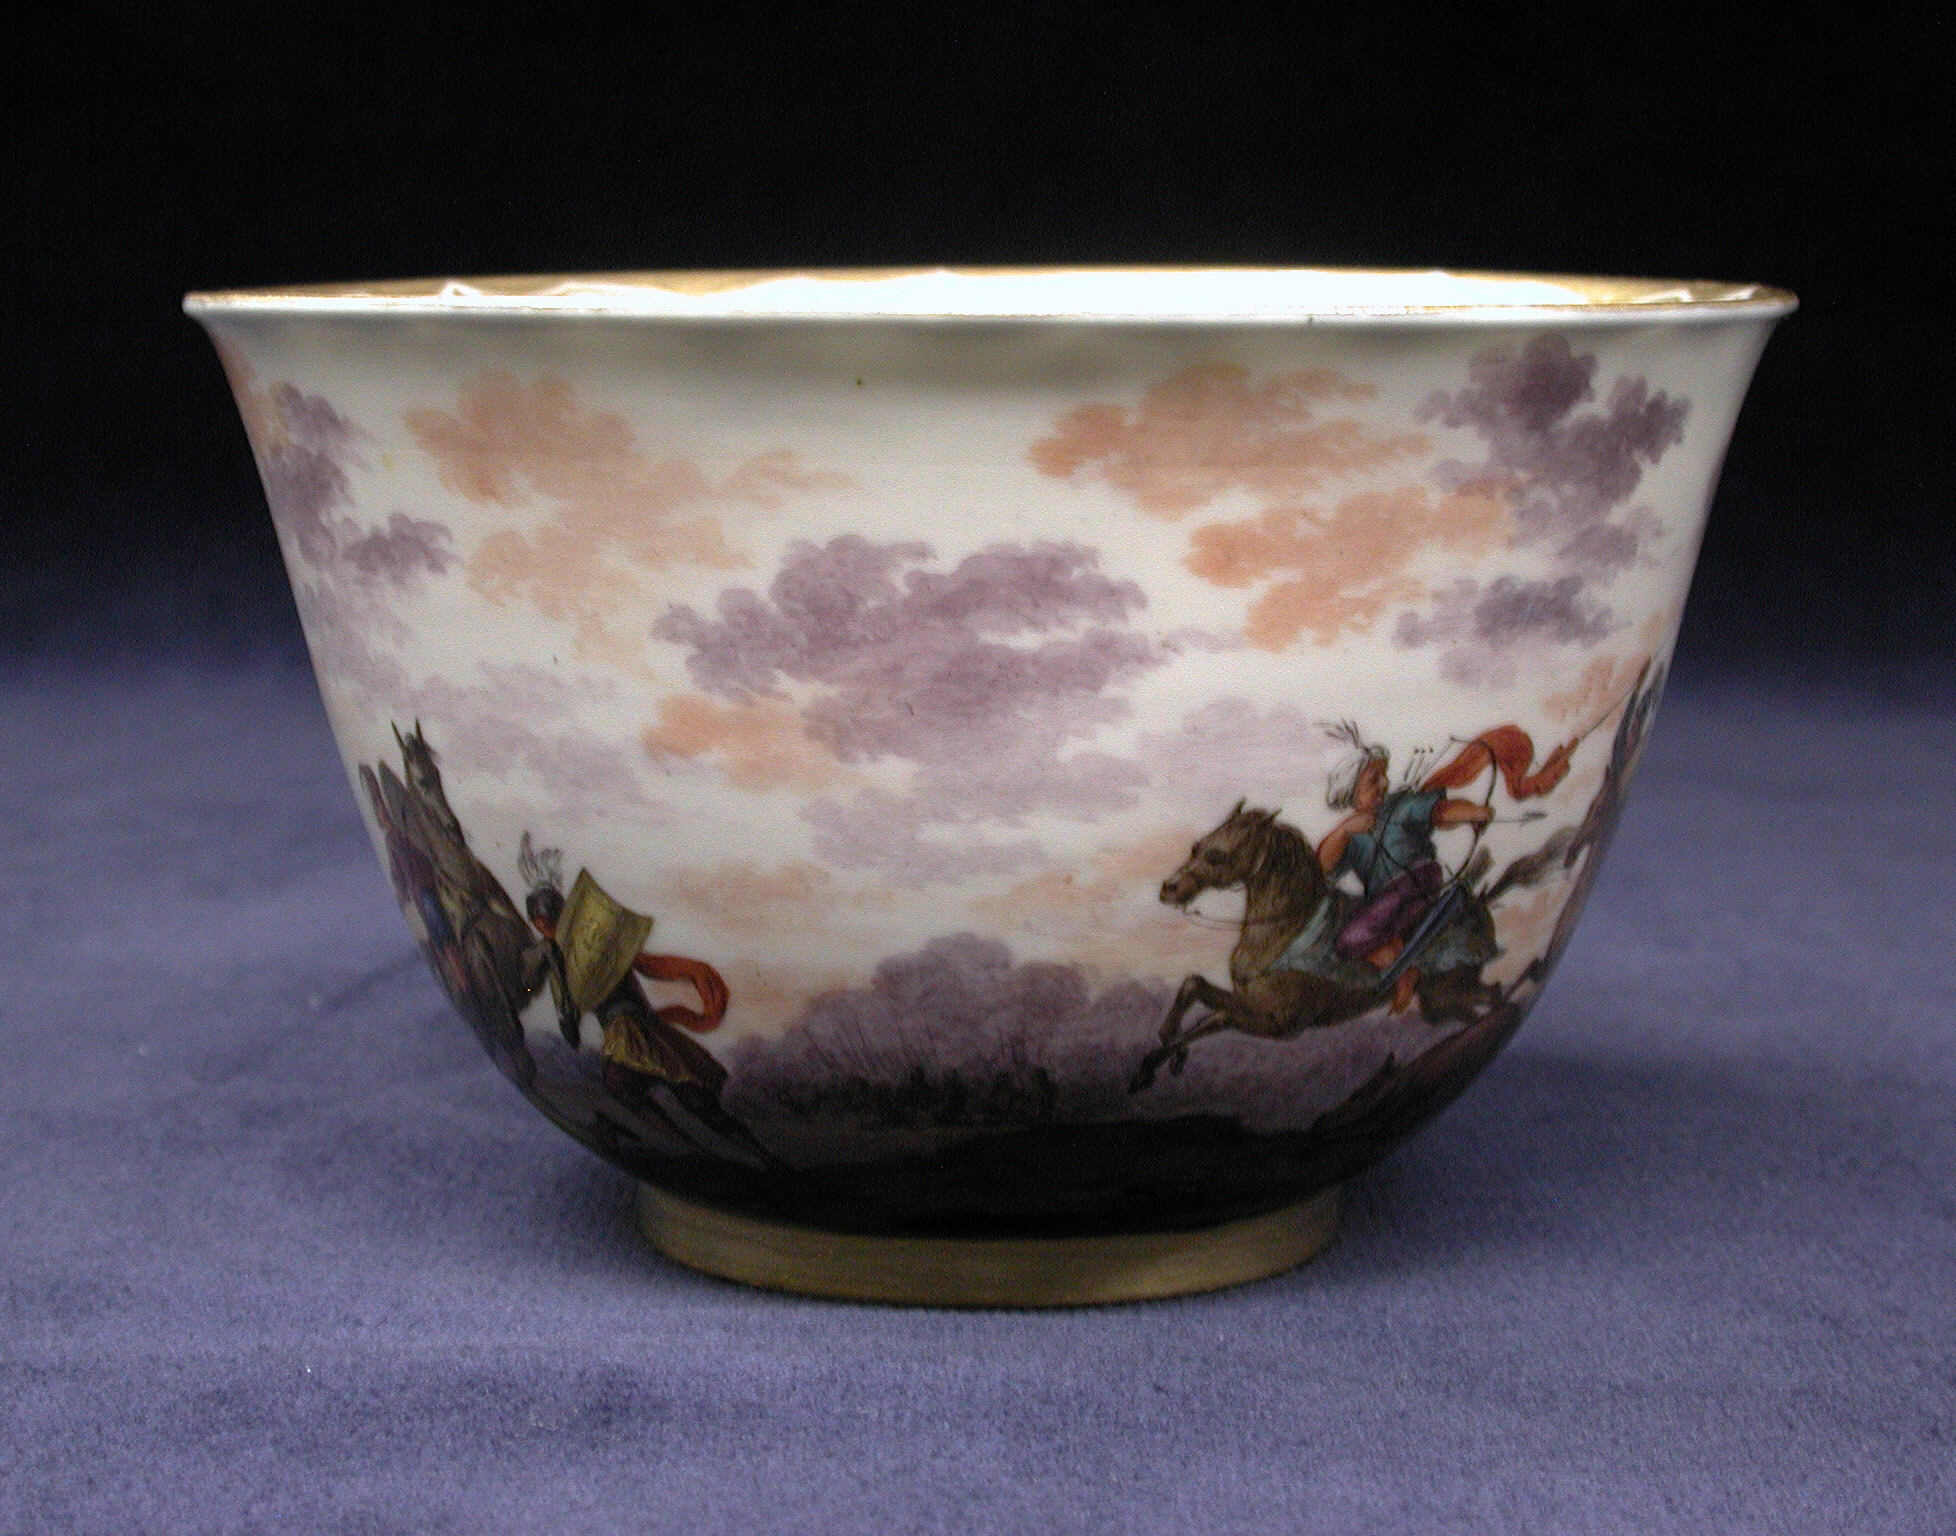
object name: bowl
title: Bowl (part of a service)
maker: capodimonte porcelain manufactory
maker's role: manufactory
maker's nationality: italian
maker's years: 1740-1759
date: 1743-1759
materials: soft paste porcelain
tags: men,horses